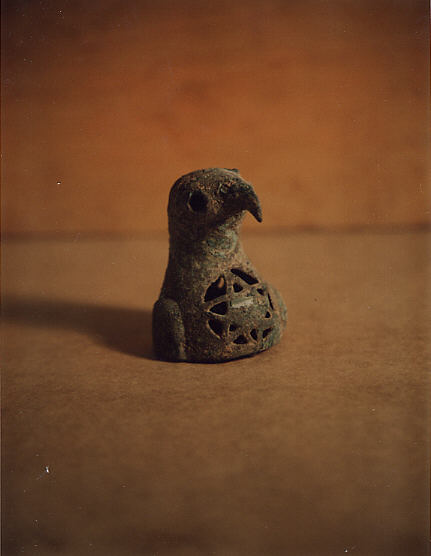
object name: incense burner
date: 1101-1300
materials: bronze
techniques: casting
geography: iran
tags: birds